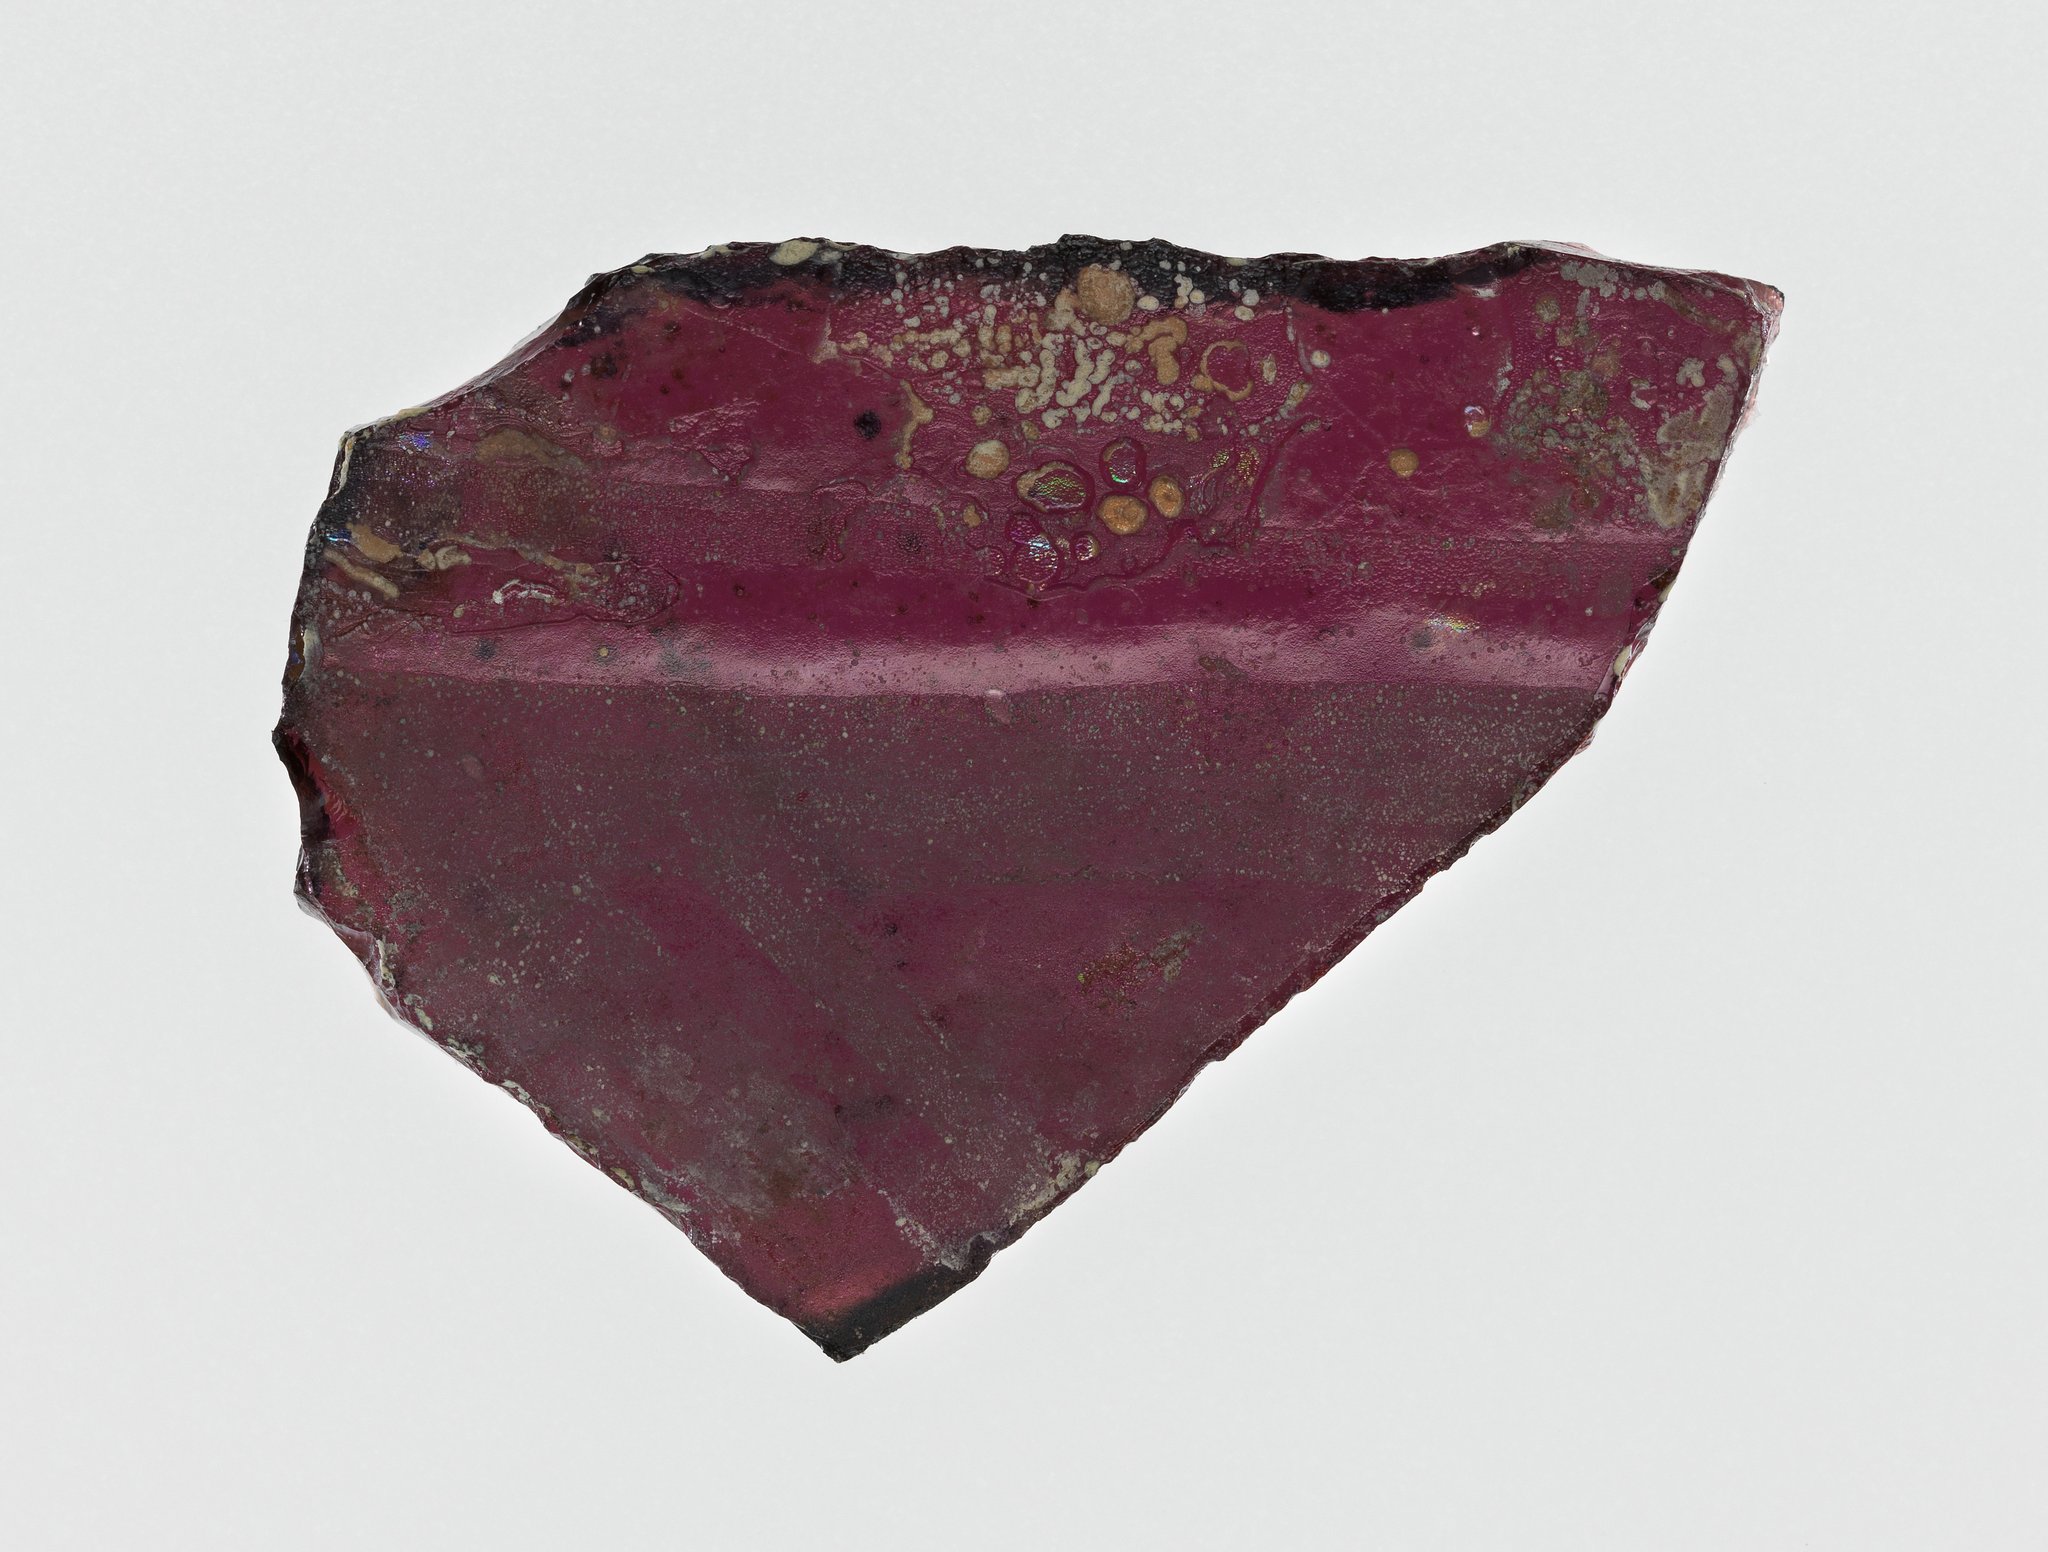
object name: fragment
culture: crusader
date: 1201-1300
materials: glass